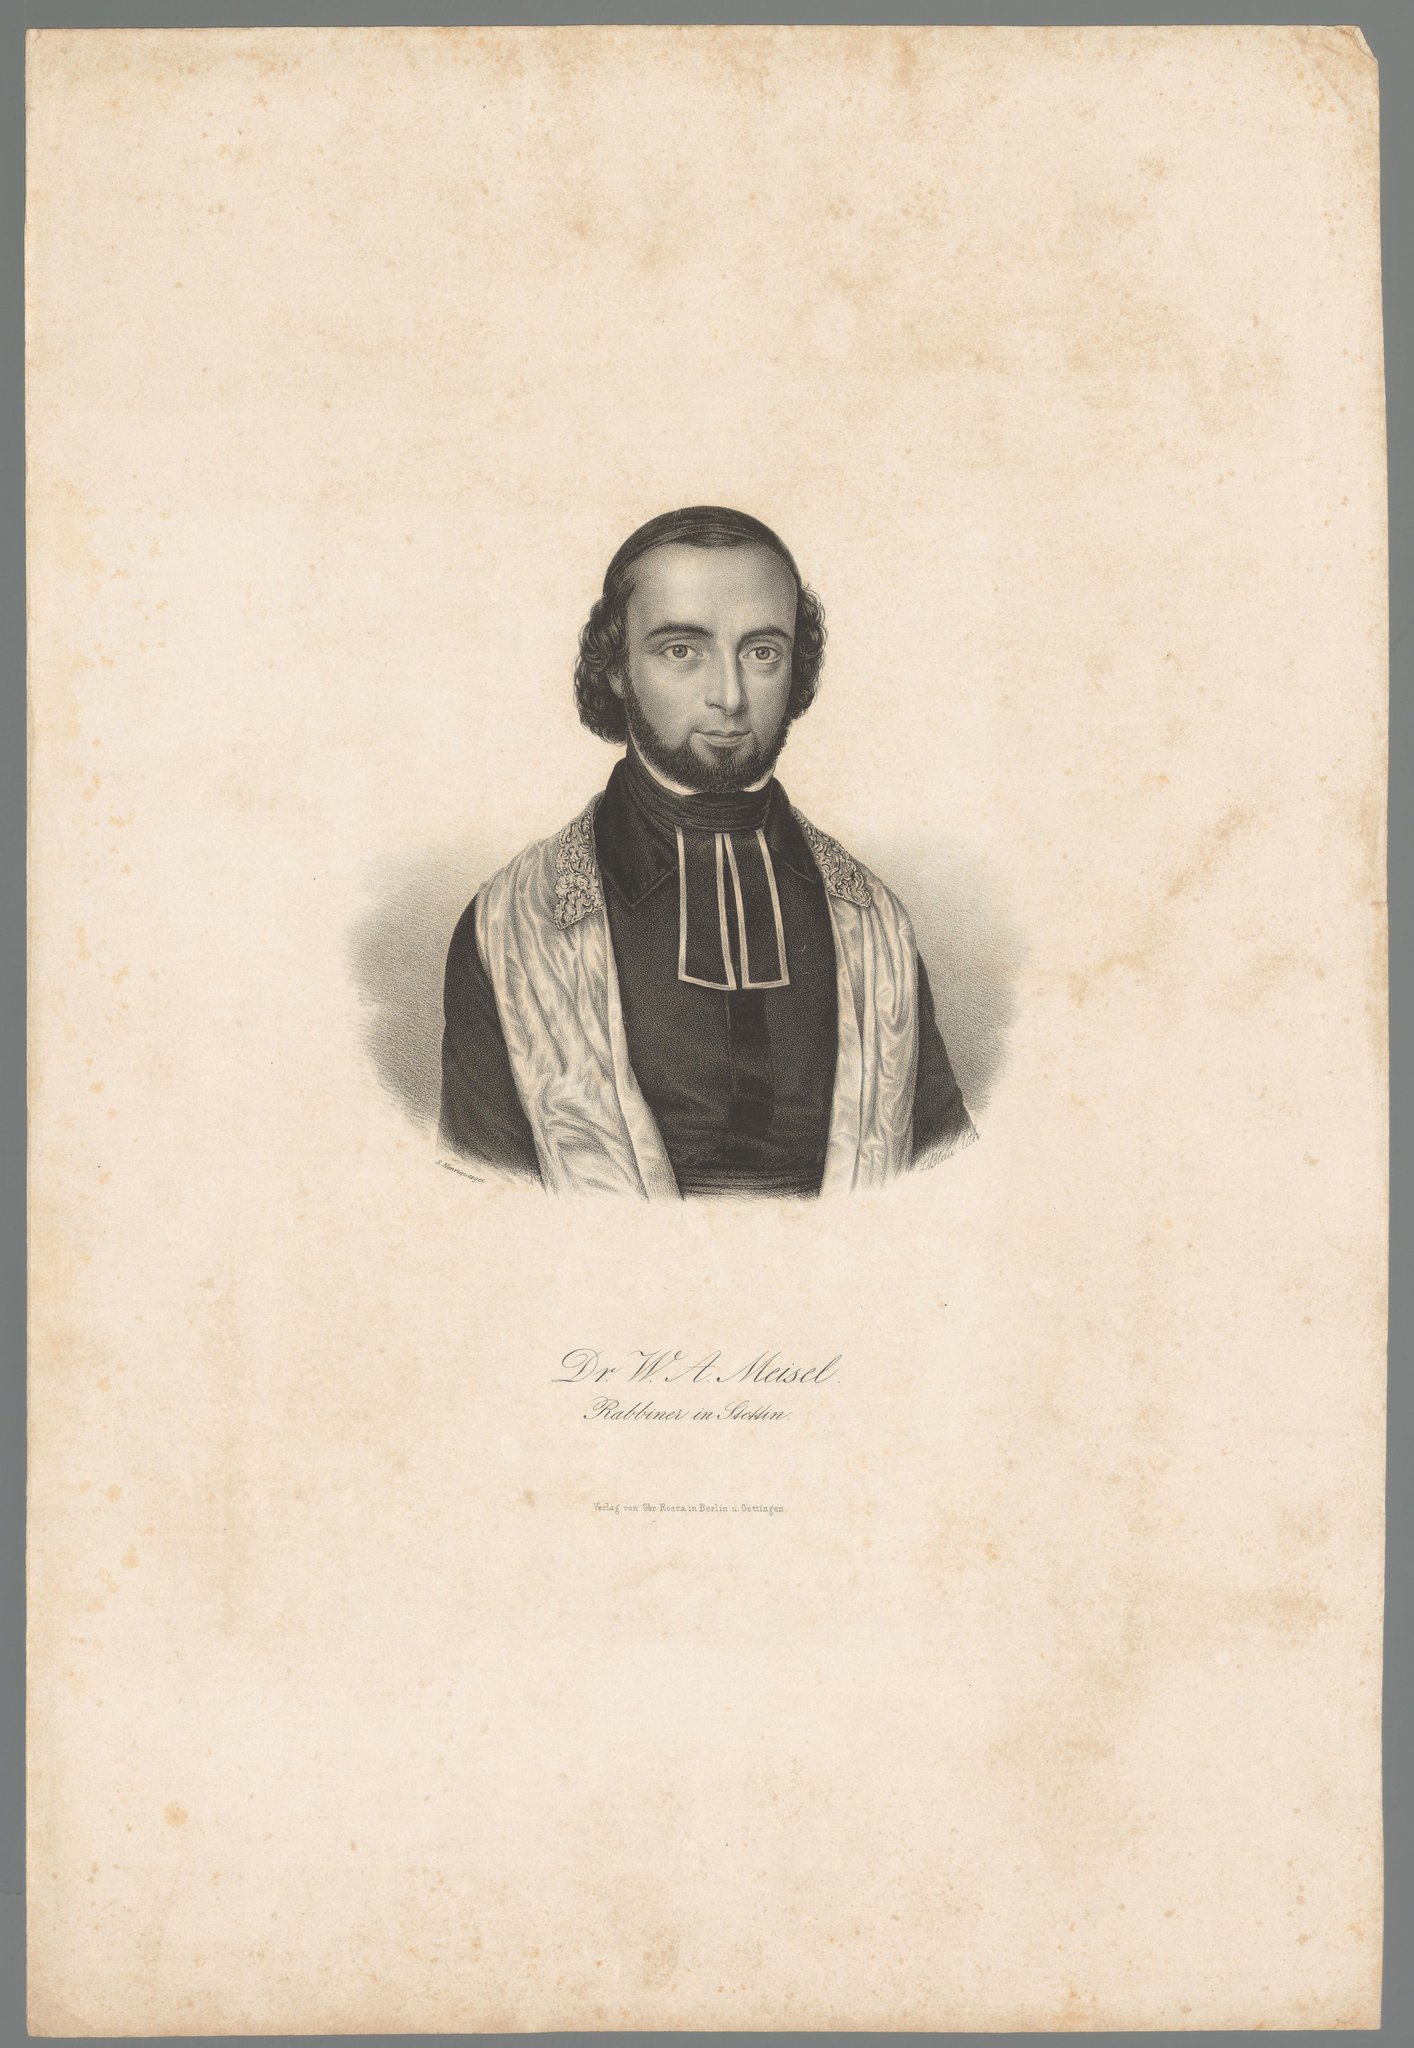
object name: print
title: Dr. W.A. Meisel, Rabbiner in Stettin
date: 1818-1874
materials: paper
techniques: lithograph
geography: berlin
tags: adult man, historical persons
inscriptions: collector's mark: Lugt 2228